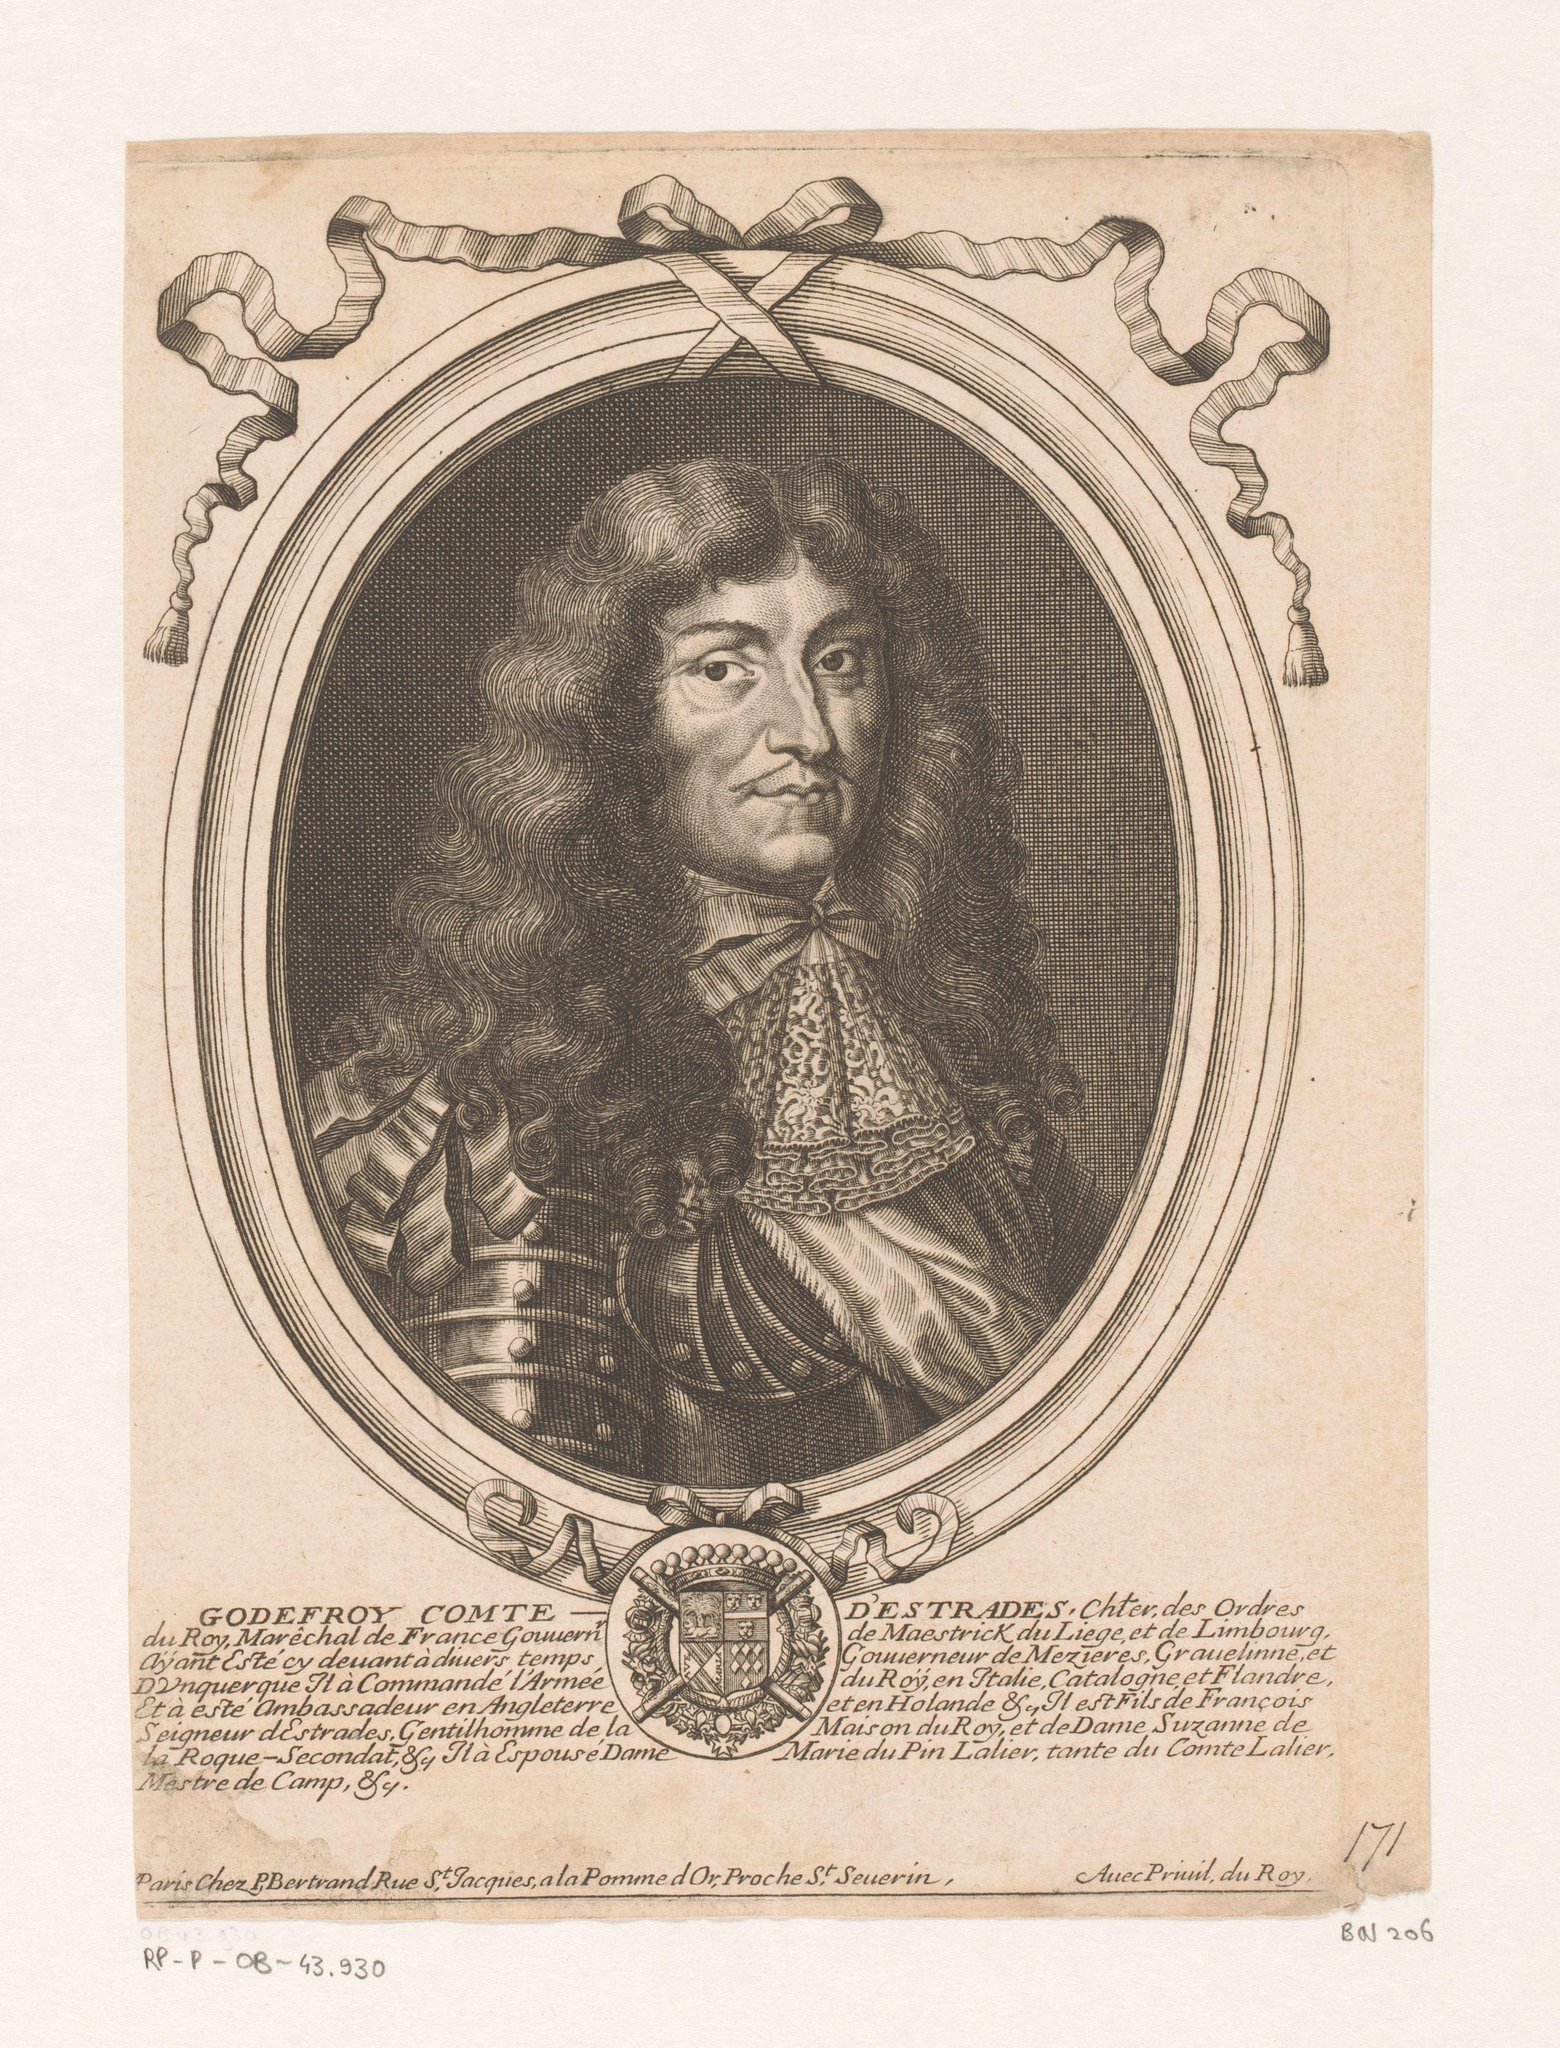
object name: print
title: Portret van Godefroi comte d'Estrades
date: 1642-1678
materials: paper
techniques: engraving, etching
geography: france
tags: commander-in-chief, general, marshal, historical persons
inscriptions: collector's mark: Lugt 2228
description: Maakt deel uit van een grootschalige serie met portretten van prominente figuren. Binnen de serie bevindt zich een sectie getiteld 'Les Augustes Représentations De tous les Roys De France depuis Pharamond Iusqu'à Louys XIIII'. De serie werd respectievelijk uitgegeven door Pierre Bertrand, door zijn weduwe en door De Larmessin zelf.